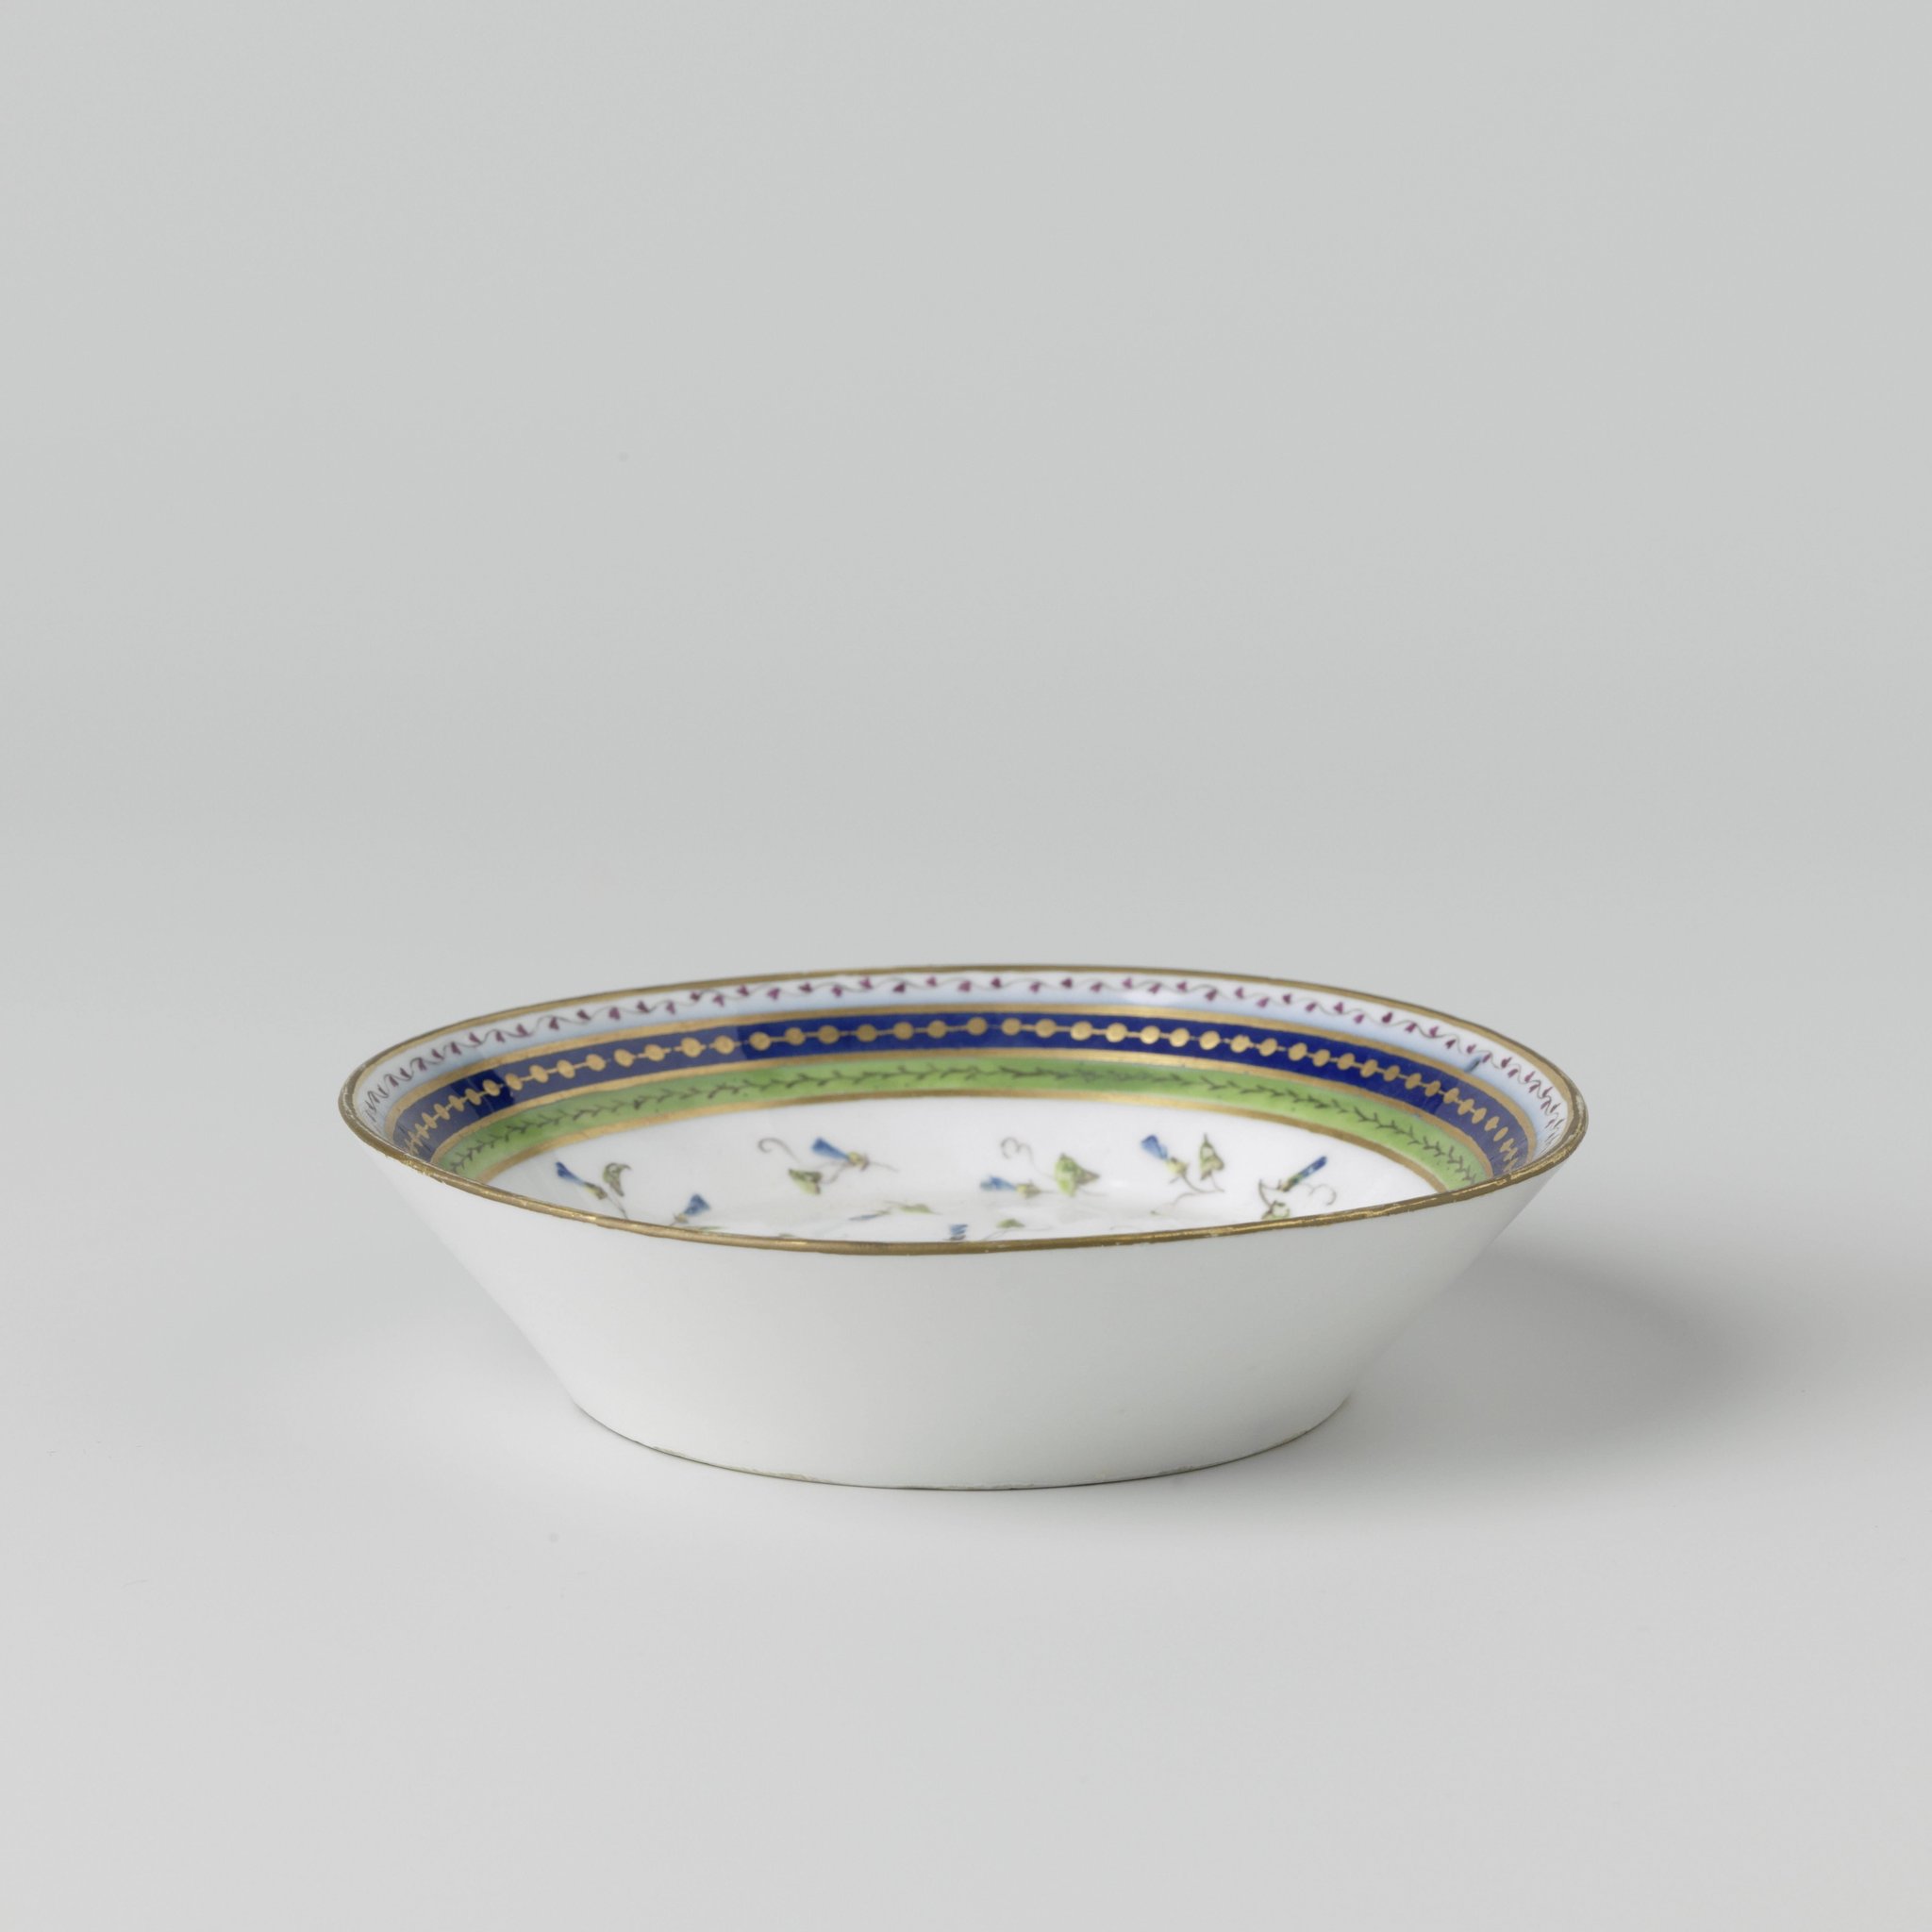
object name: platter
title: Saucer with a medallion among flowers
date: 1777-1788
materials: cobalt, glaze, gold, paint, porcelain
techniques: firing, forming, gilding, turning, vitrification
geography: sèvres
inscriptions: mark: ‘dubbele L/ KK en Y/ kroon met kruis’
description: Schotel van porselein met een rechte wand, beschilderd in onderglazuur blauw en op het glazuur in blauw, roze, groen, geel, zwart en goud. Op het plat een medaillom met een bloemtak omringd door strooibloemen. De wand met een decoratieve band met een zwarte bladrank tegen een groene achtergrond, een gouden band met stippen op onderglazuur blauw en een bloemrank. Gemerkt op de onderzijde met de dubbele L met de jaarletters KK en Y.